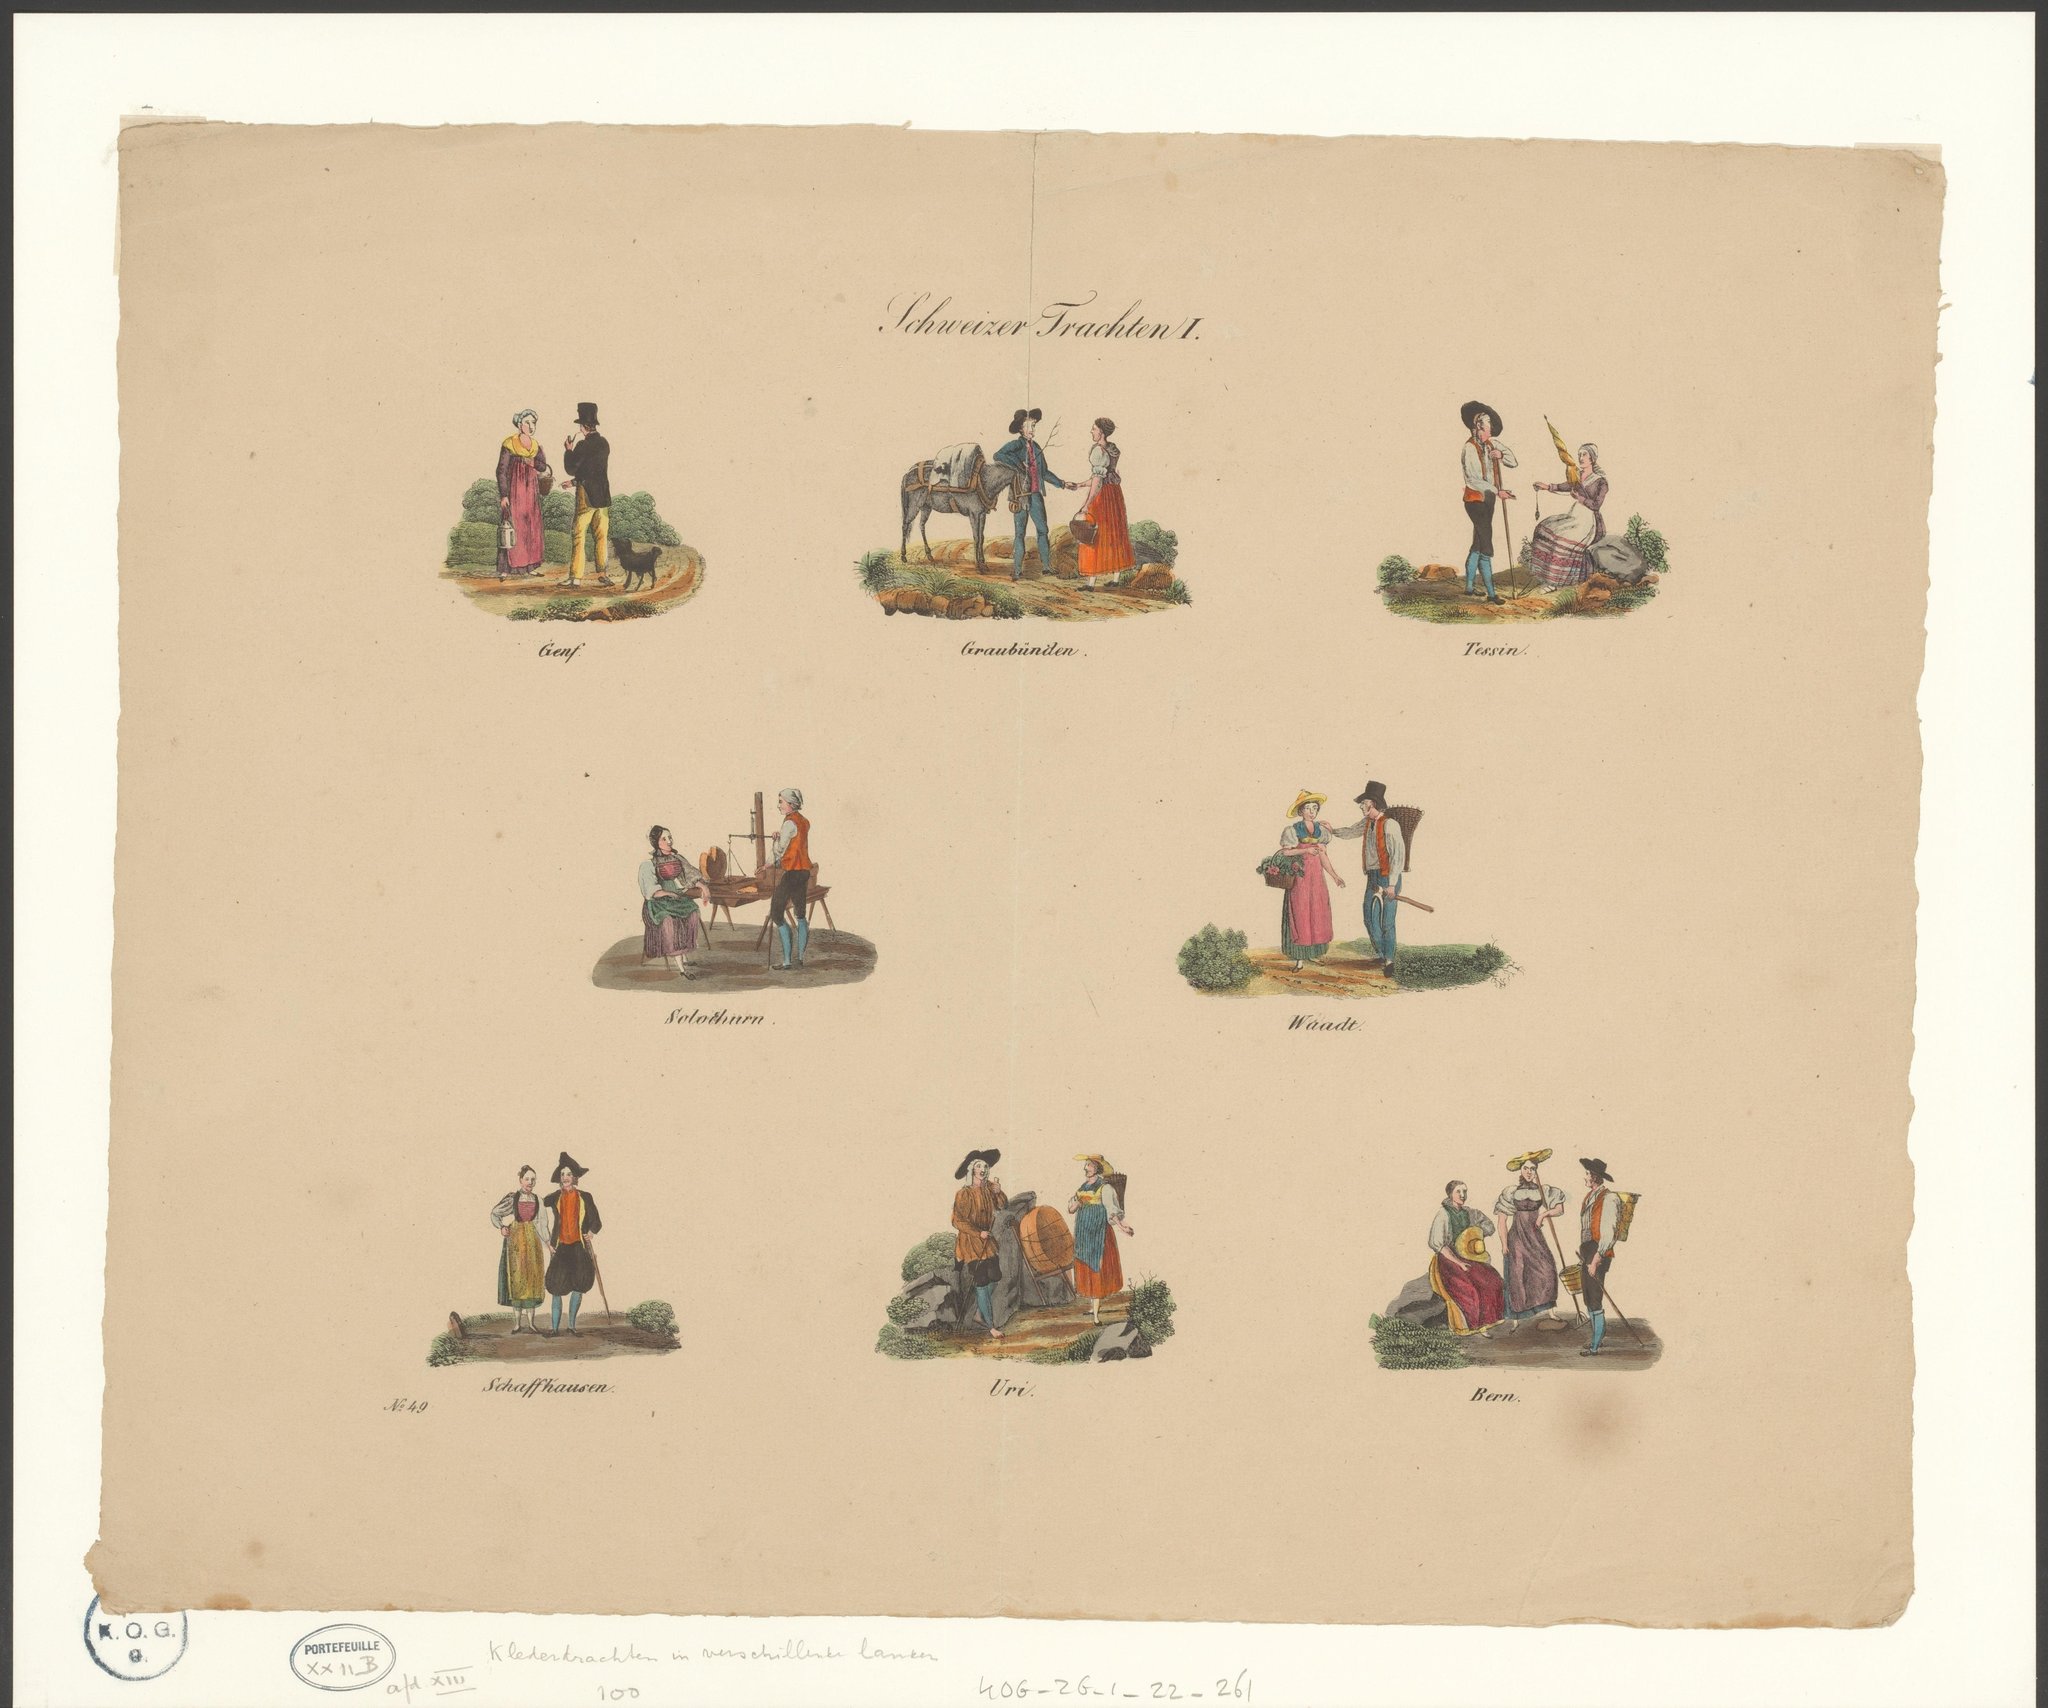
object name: popular print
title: Schweizer Trachten I.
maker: Anonymous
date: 1800-1899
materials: paper, watercolor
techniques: hand coloring, engraving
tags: clothes, costume (+ women's clothes), clothes, costume (+ men's clothes), folk costume, regional costume, switzerland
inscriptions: collector's mark: Lugt 1641, collector's mark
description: Blad met acht scènes met personen in Zwitserse klederdracht. Linksonder genummerd: No. 49. Onderwerpsrubrieken binnen de Atlas Zeden en Gewoonten: De Kleeding, Volkskleederdracht, buitenland.